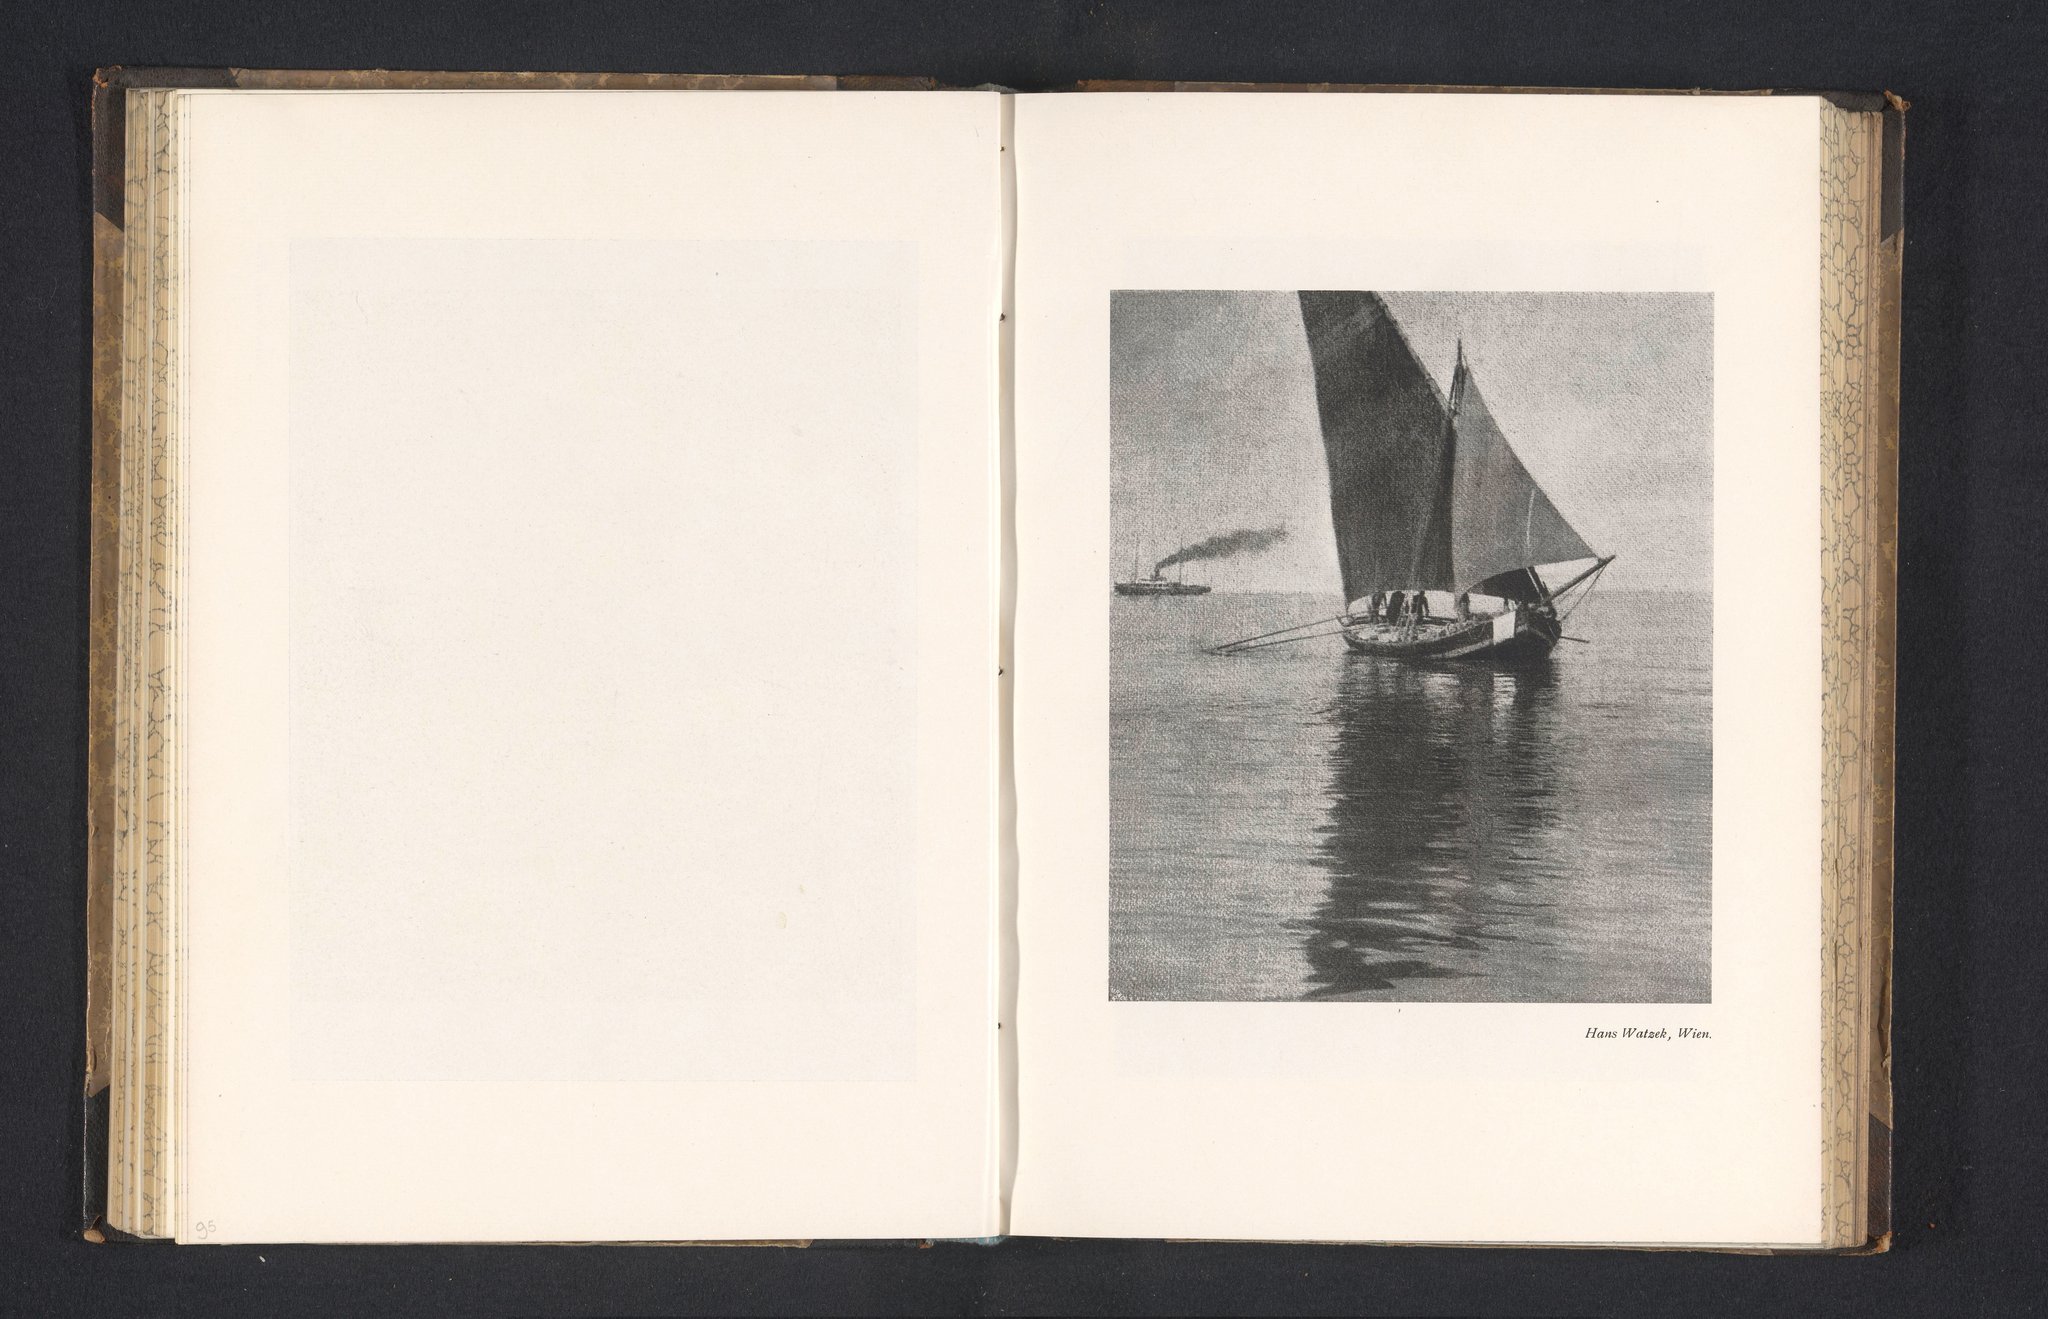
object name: page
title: Zeilschip op open water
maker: hans watzek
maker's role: draughtsman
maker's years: 1848-1903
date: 1898-1903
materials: paper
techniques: autotype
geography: berlin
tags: sailing-ship, sailing-boat, sea (seascape)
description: Prent op derde ongenummerde pagina na pagina 160.